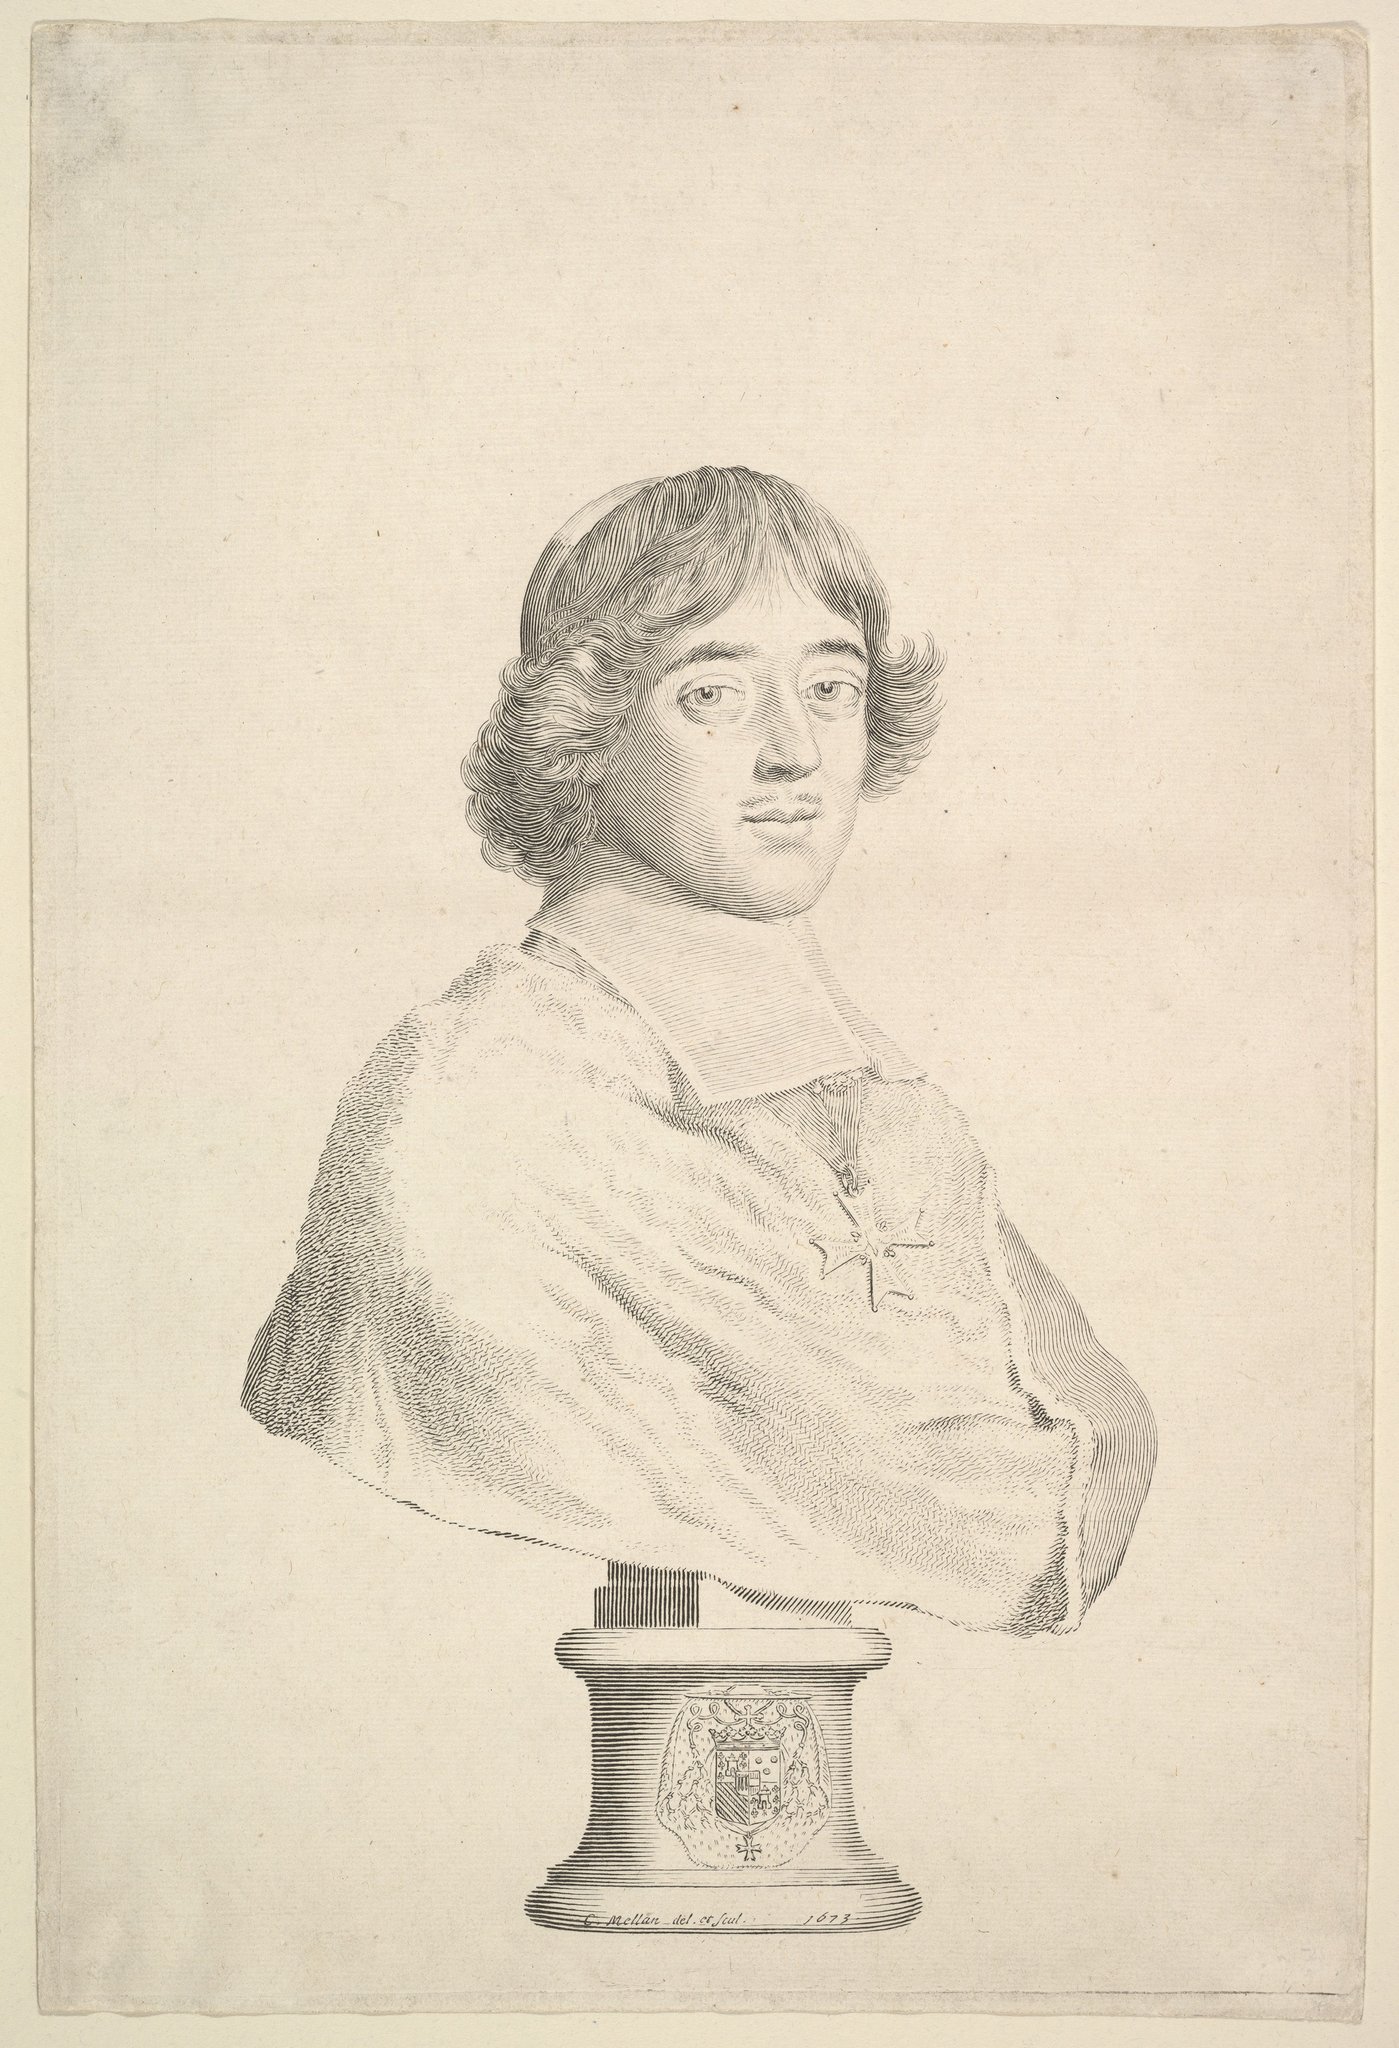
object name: print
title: Emmanuel-Théodose de La Tour d'Auvergne, duc d'Albret et cardinal de Bouillon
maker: claude mellan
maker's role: artist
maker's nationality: french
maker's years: 1598-1688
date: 1673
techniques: engraving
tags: men,portraits,coat of arms